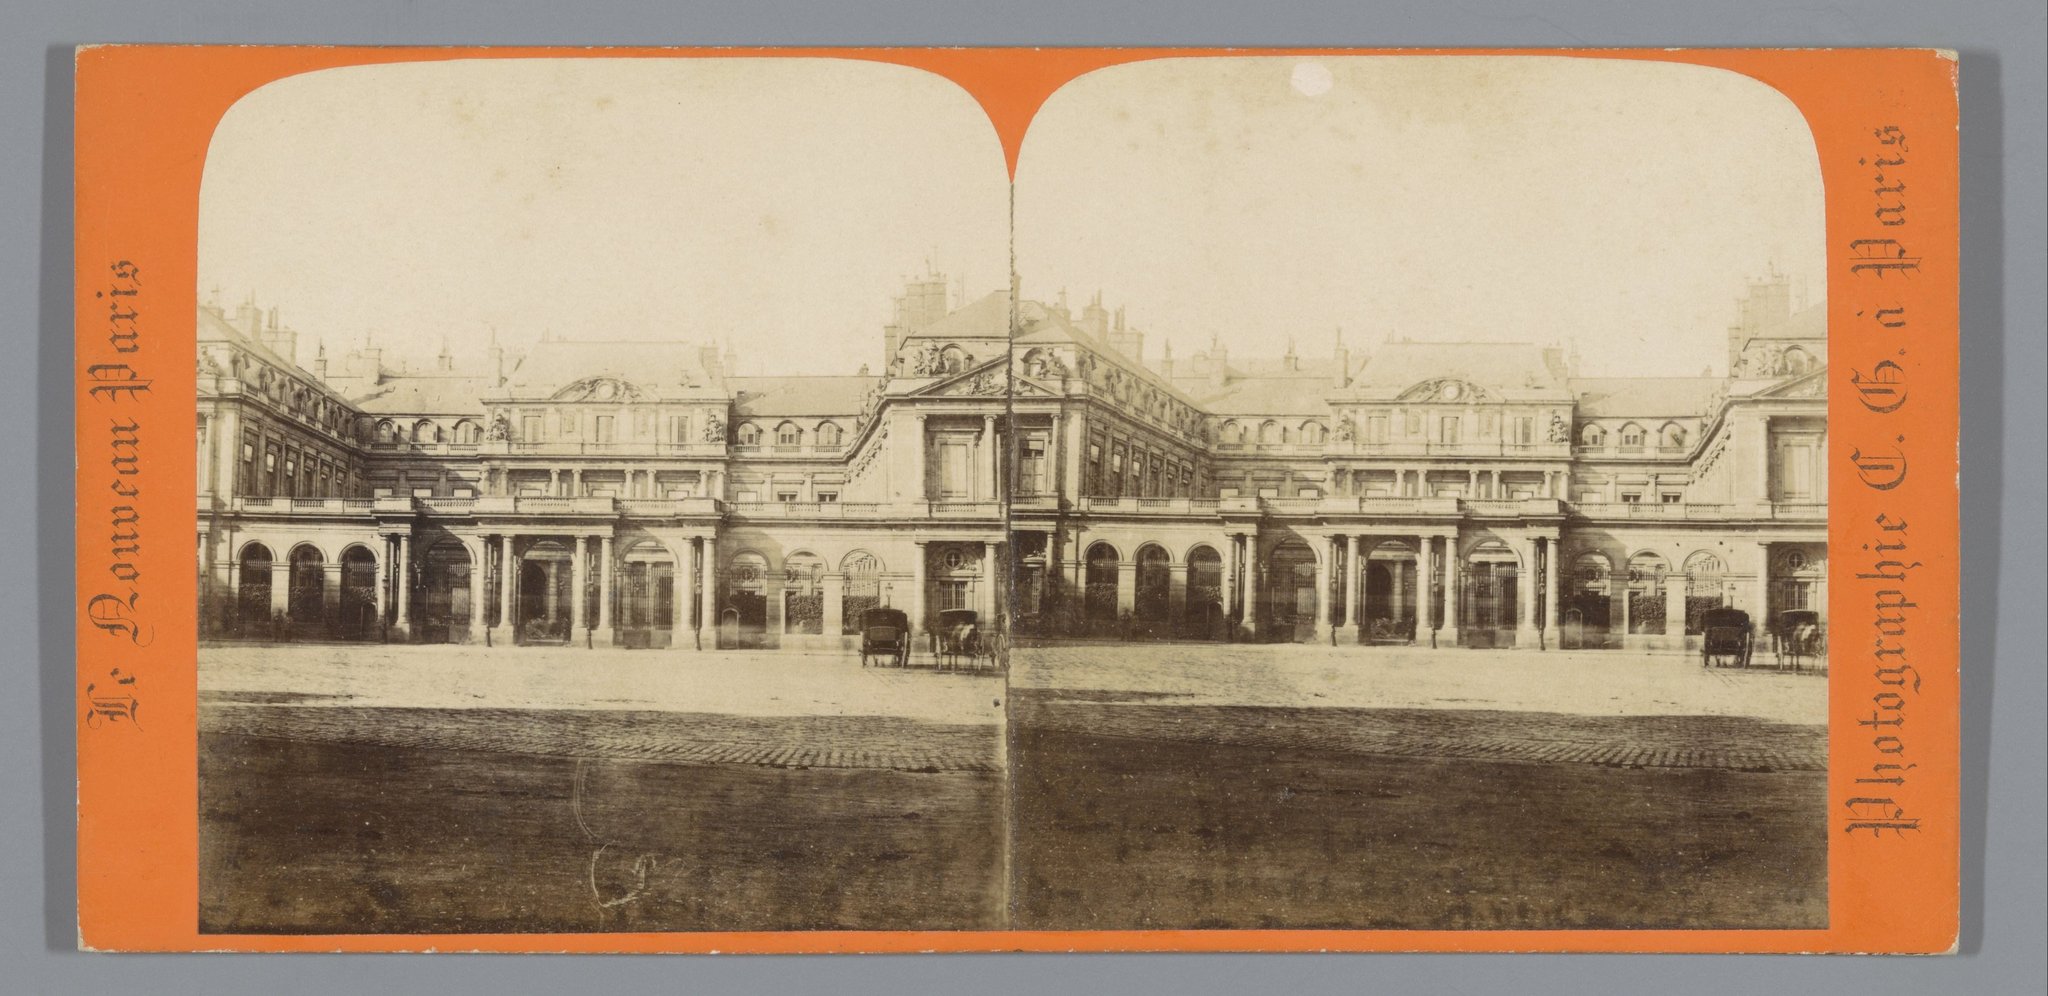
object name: stereograph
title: Voorgevel van het Palais-Royal te Parijs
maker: charles gérard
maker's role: fotograaf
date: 1860-1870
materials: cardboard, photographic support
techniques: albumen print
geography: paris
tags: palace, façade (of house or building)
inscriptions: inscription: ‘Photographie C. G. à Paris.’, inscription: ‘Palais royal’